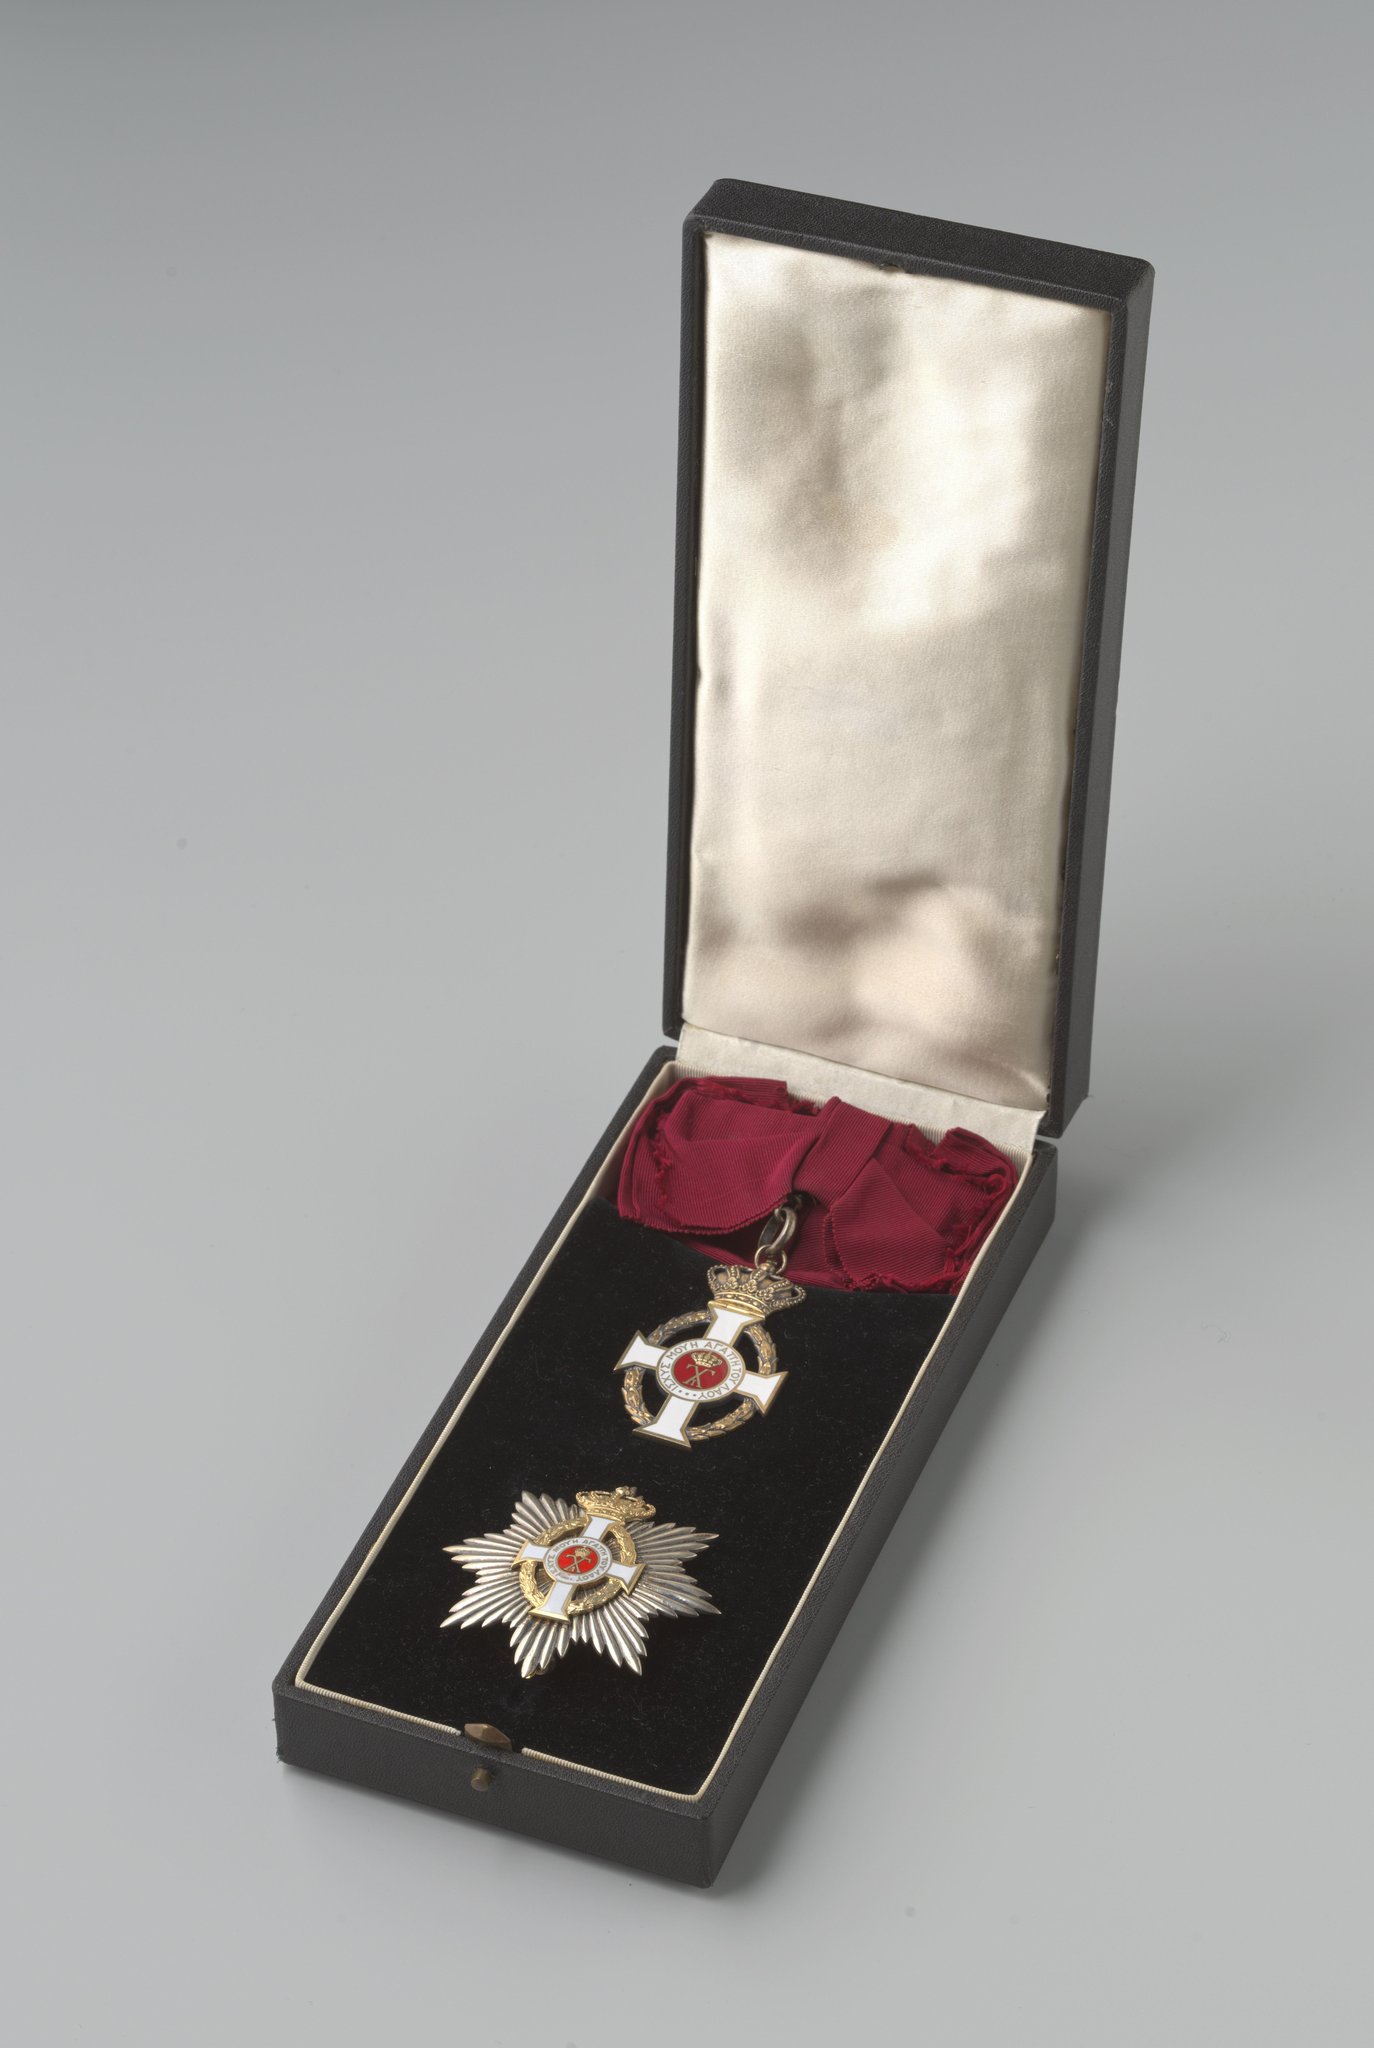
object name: ordeteken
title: Griekse orde (Orde van George I), ontvangen door Willem Drees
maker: Anonymous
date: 1954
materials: silver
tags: amsterdam, willem drees, netherlands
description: Het Grootkruis van de Orde van George I werd minister-president W. Drees verleend door Paul, koning der Grieken, in juni 1954 ter gelegenheid van het bezoek van de minister-president van Griekenland, veldmaarschalk Alexander Papagos, aan Nederland op 2 februari 1954.